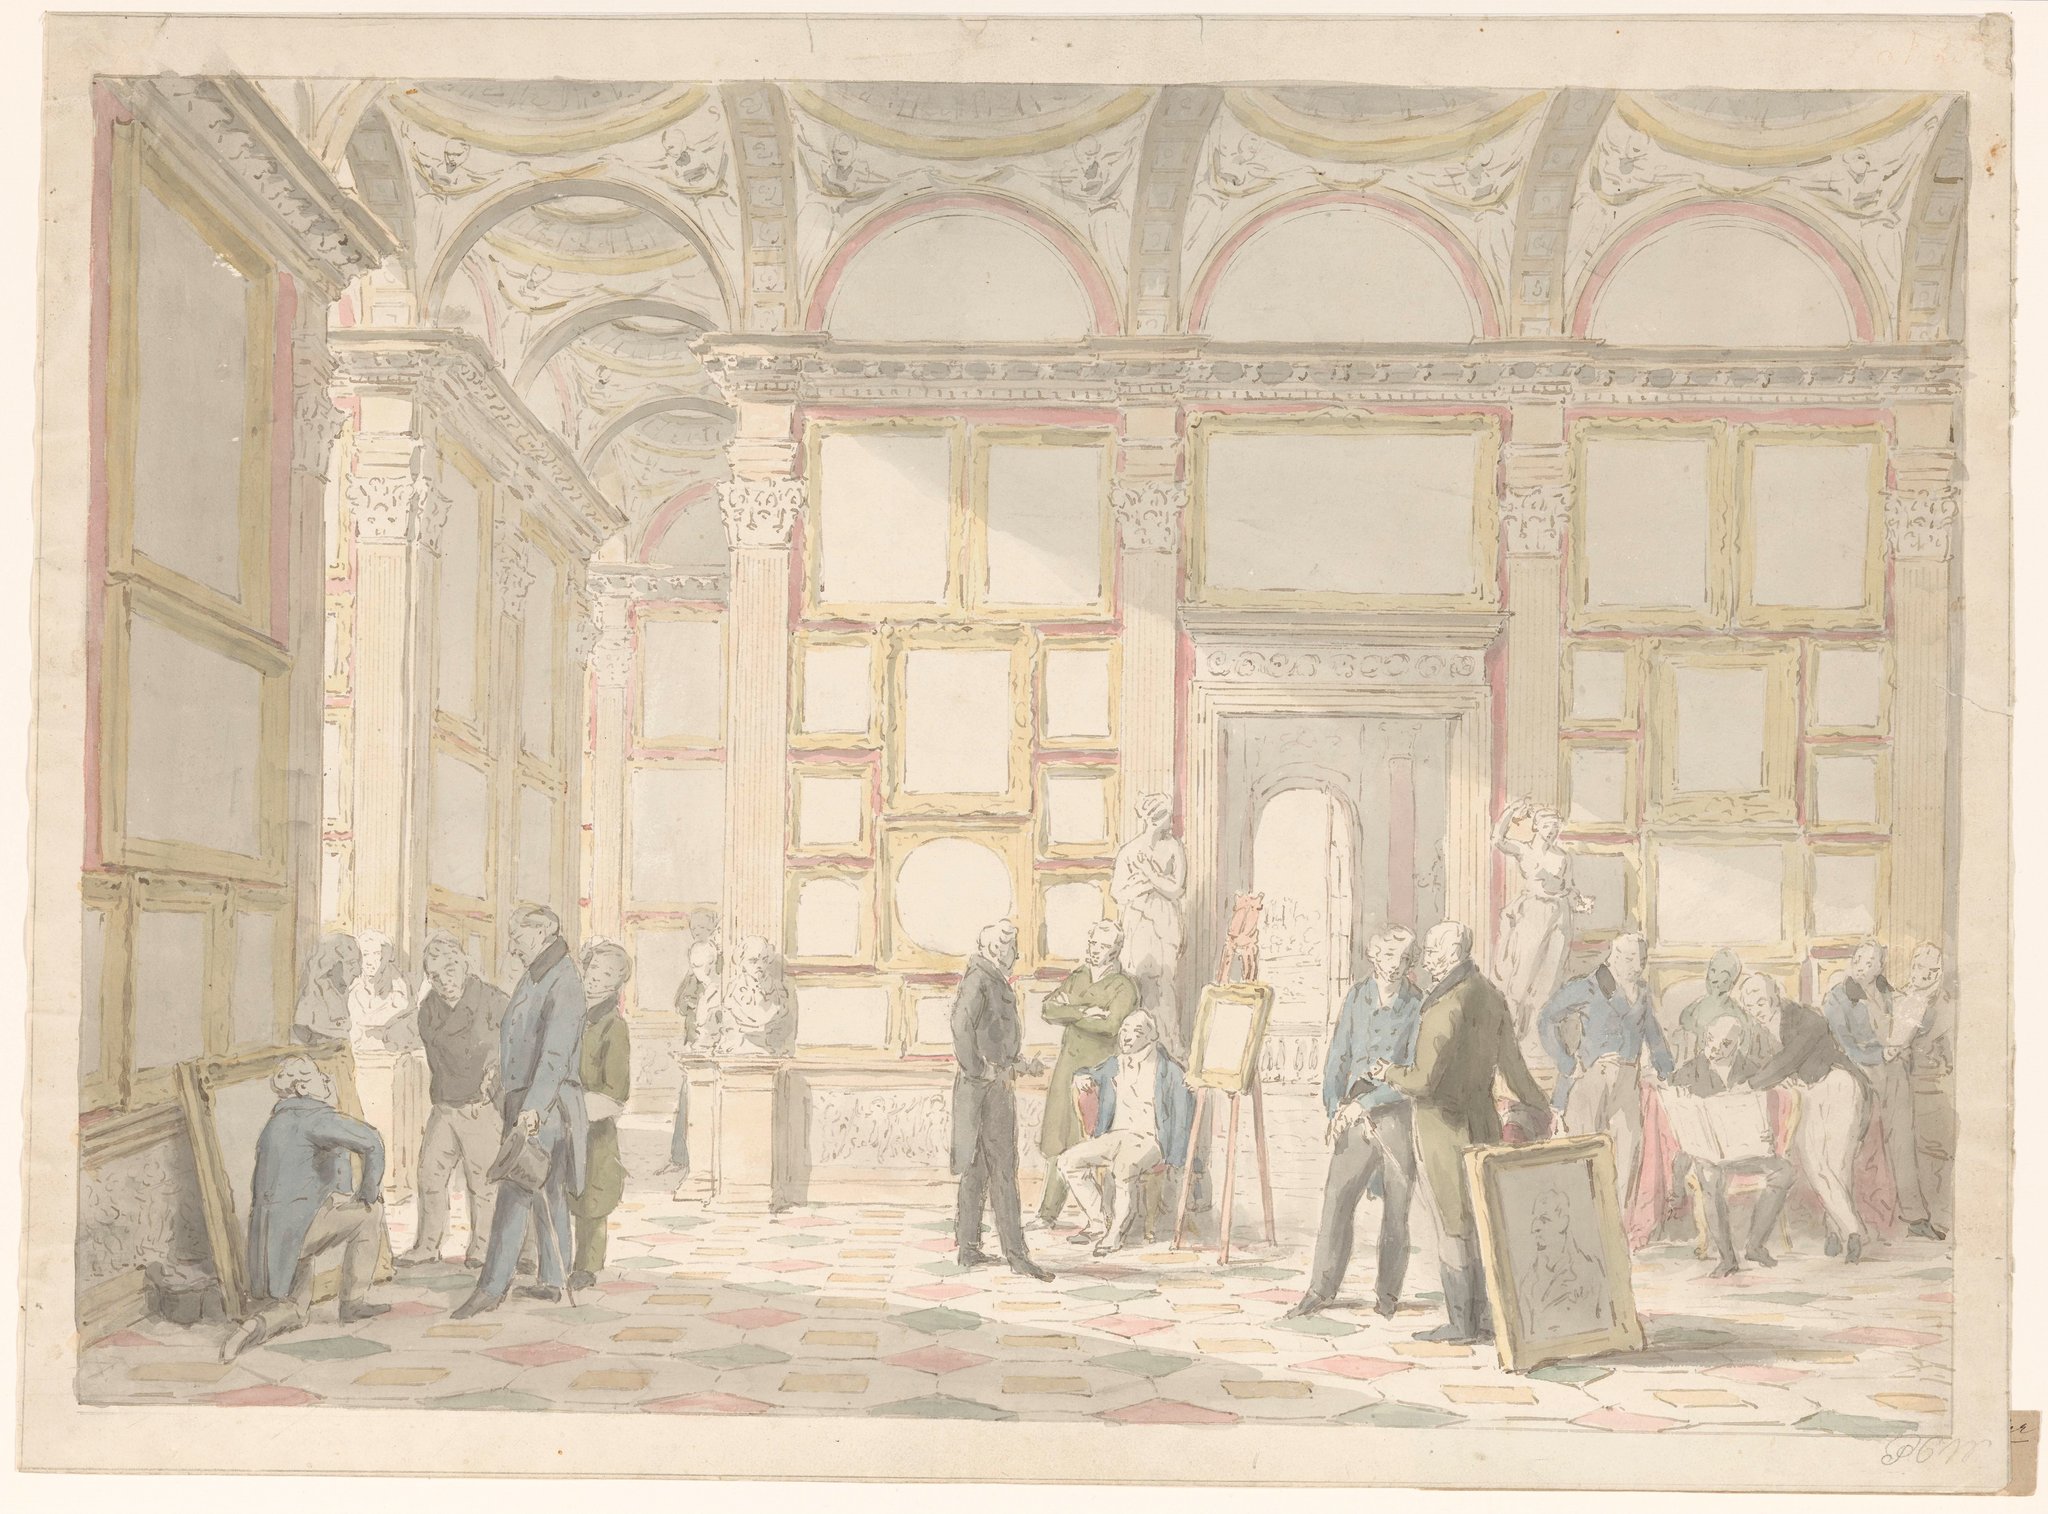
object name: drawing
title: Kunstliefhebbers in een galerij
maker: pieter christoffel wonder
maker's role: draughtsman, painter, print maker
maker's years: 1780-1852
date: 1826-1830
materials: paper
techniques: brush, pen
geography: london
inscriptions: inscription: ‘Schets van een schilderij van Wonder geschilderd voor Lord Murray, te Londen.’